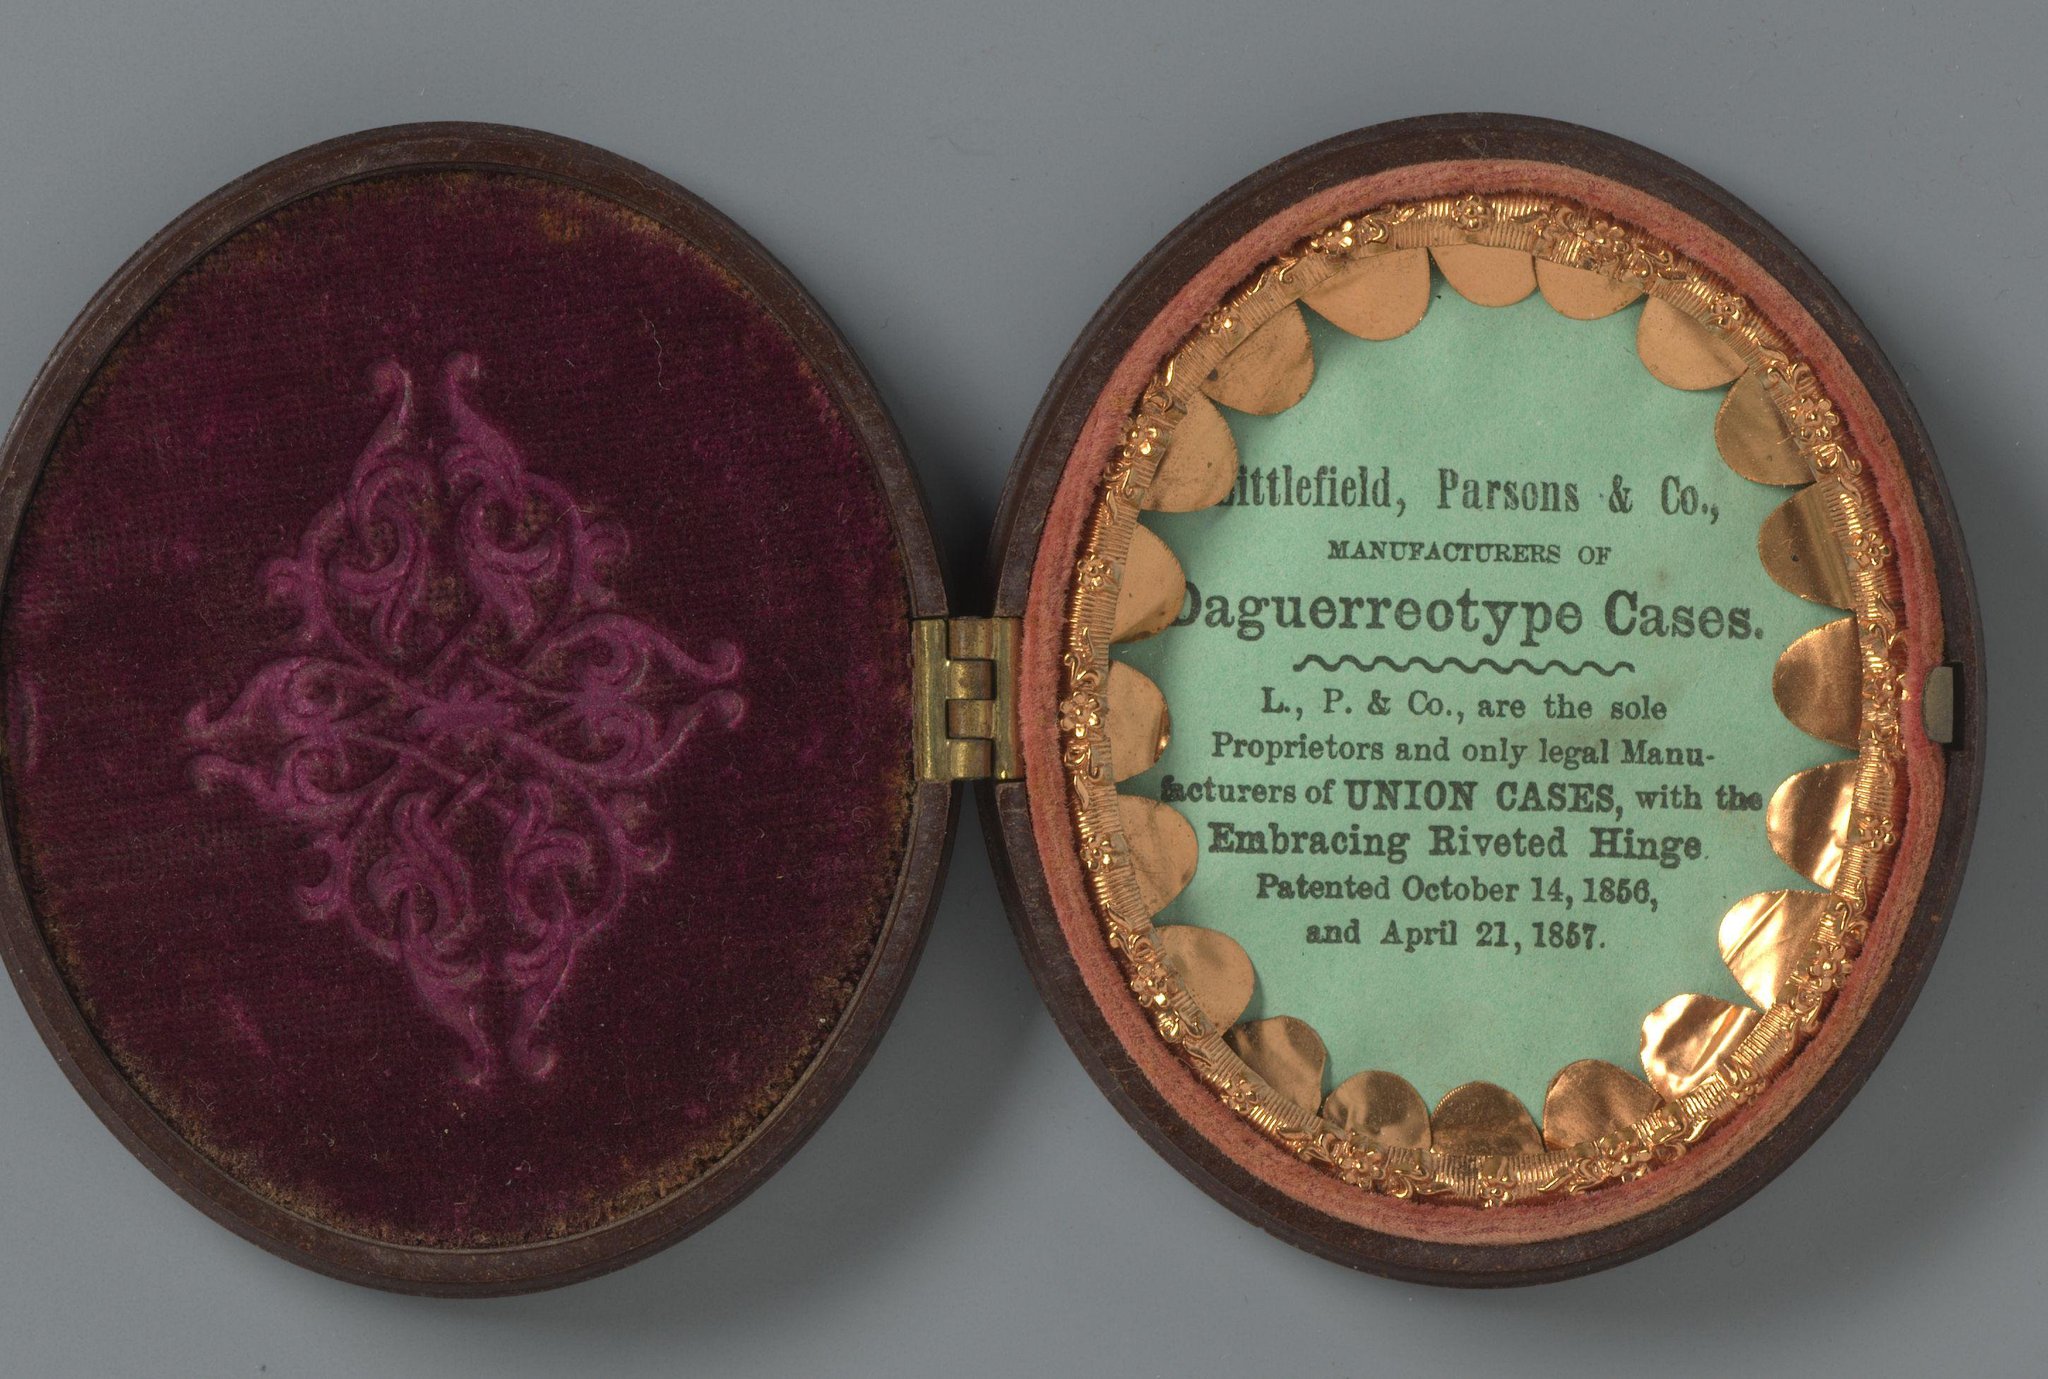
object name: photograph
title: union case(leeg)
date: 1858-1866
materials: glass, metal, velvet, wood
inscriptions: inscription: ‘Litteliefd, Pasons & Co./ Manufacturers of/ Daguerreotype Cases/ Lt, P. & Co. are the sole/ Proprietors and only legal/ Manu-/ facturers of Union Cases, with the/ Embracing Riveted Hinge/ Patented October 14, 1856,/ and April 21, 1857’